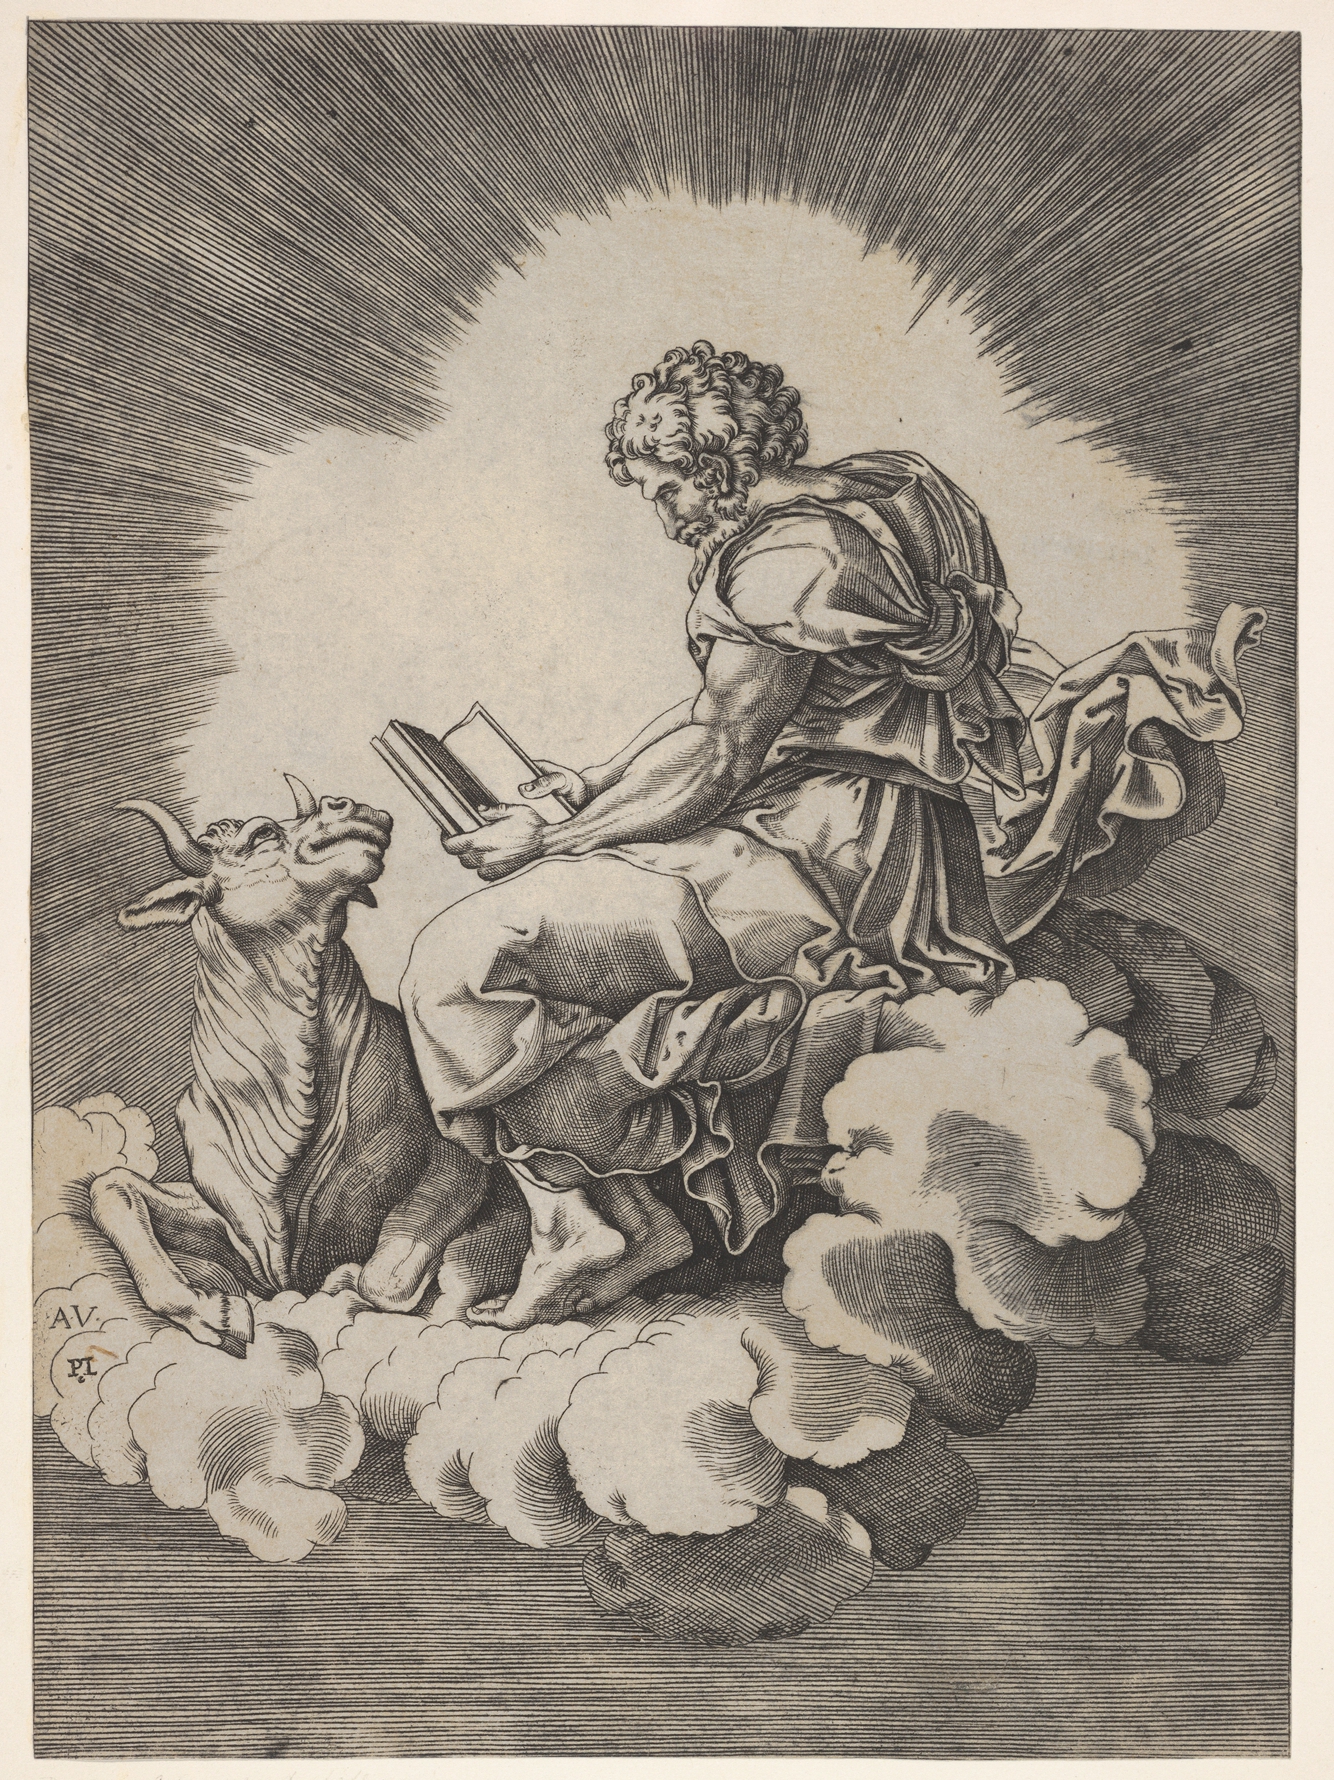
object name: print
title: St. Luke, seated on a cloud with an open book in both hands, a bull lying at his feet, from a series of the four evangelists after Agostino Veneziano, which are in turn after Giulio Romano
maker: anonymous, italian, 16th century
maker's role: artist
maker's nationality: italian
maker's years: 1500-1600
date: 1518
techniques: engraving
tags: books,men,bulls,saint luke